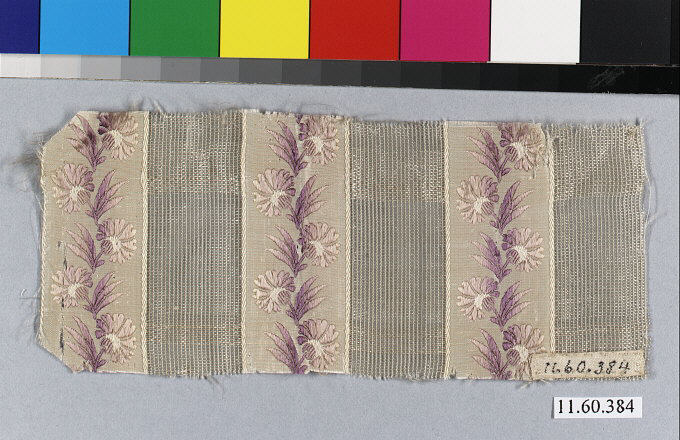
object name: fragment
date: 1801-1900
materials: silk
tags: flowers,leaves